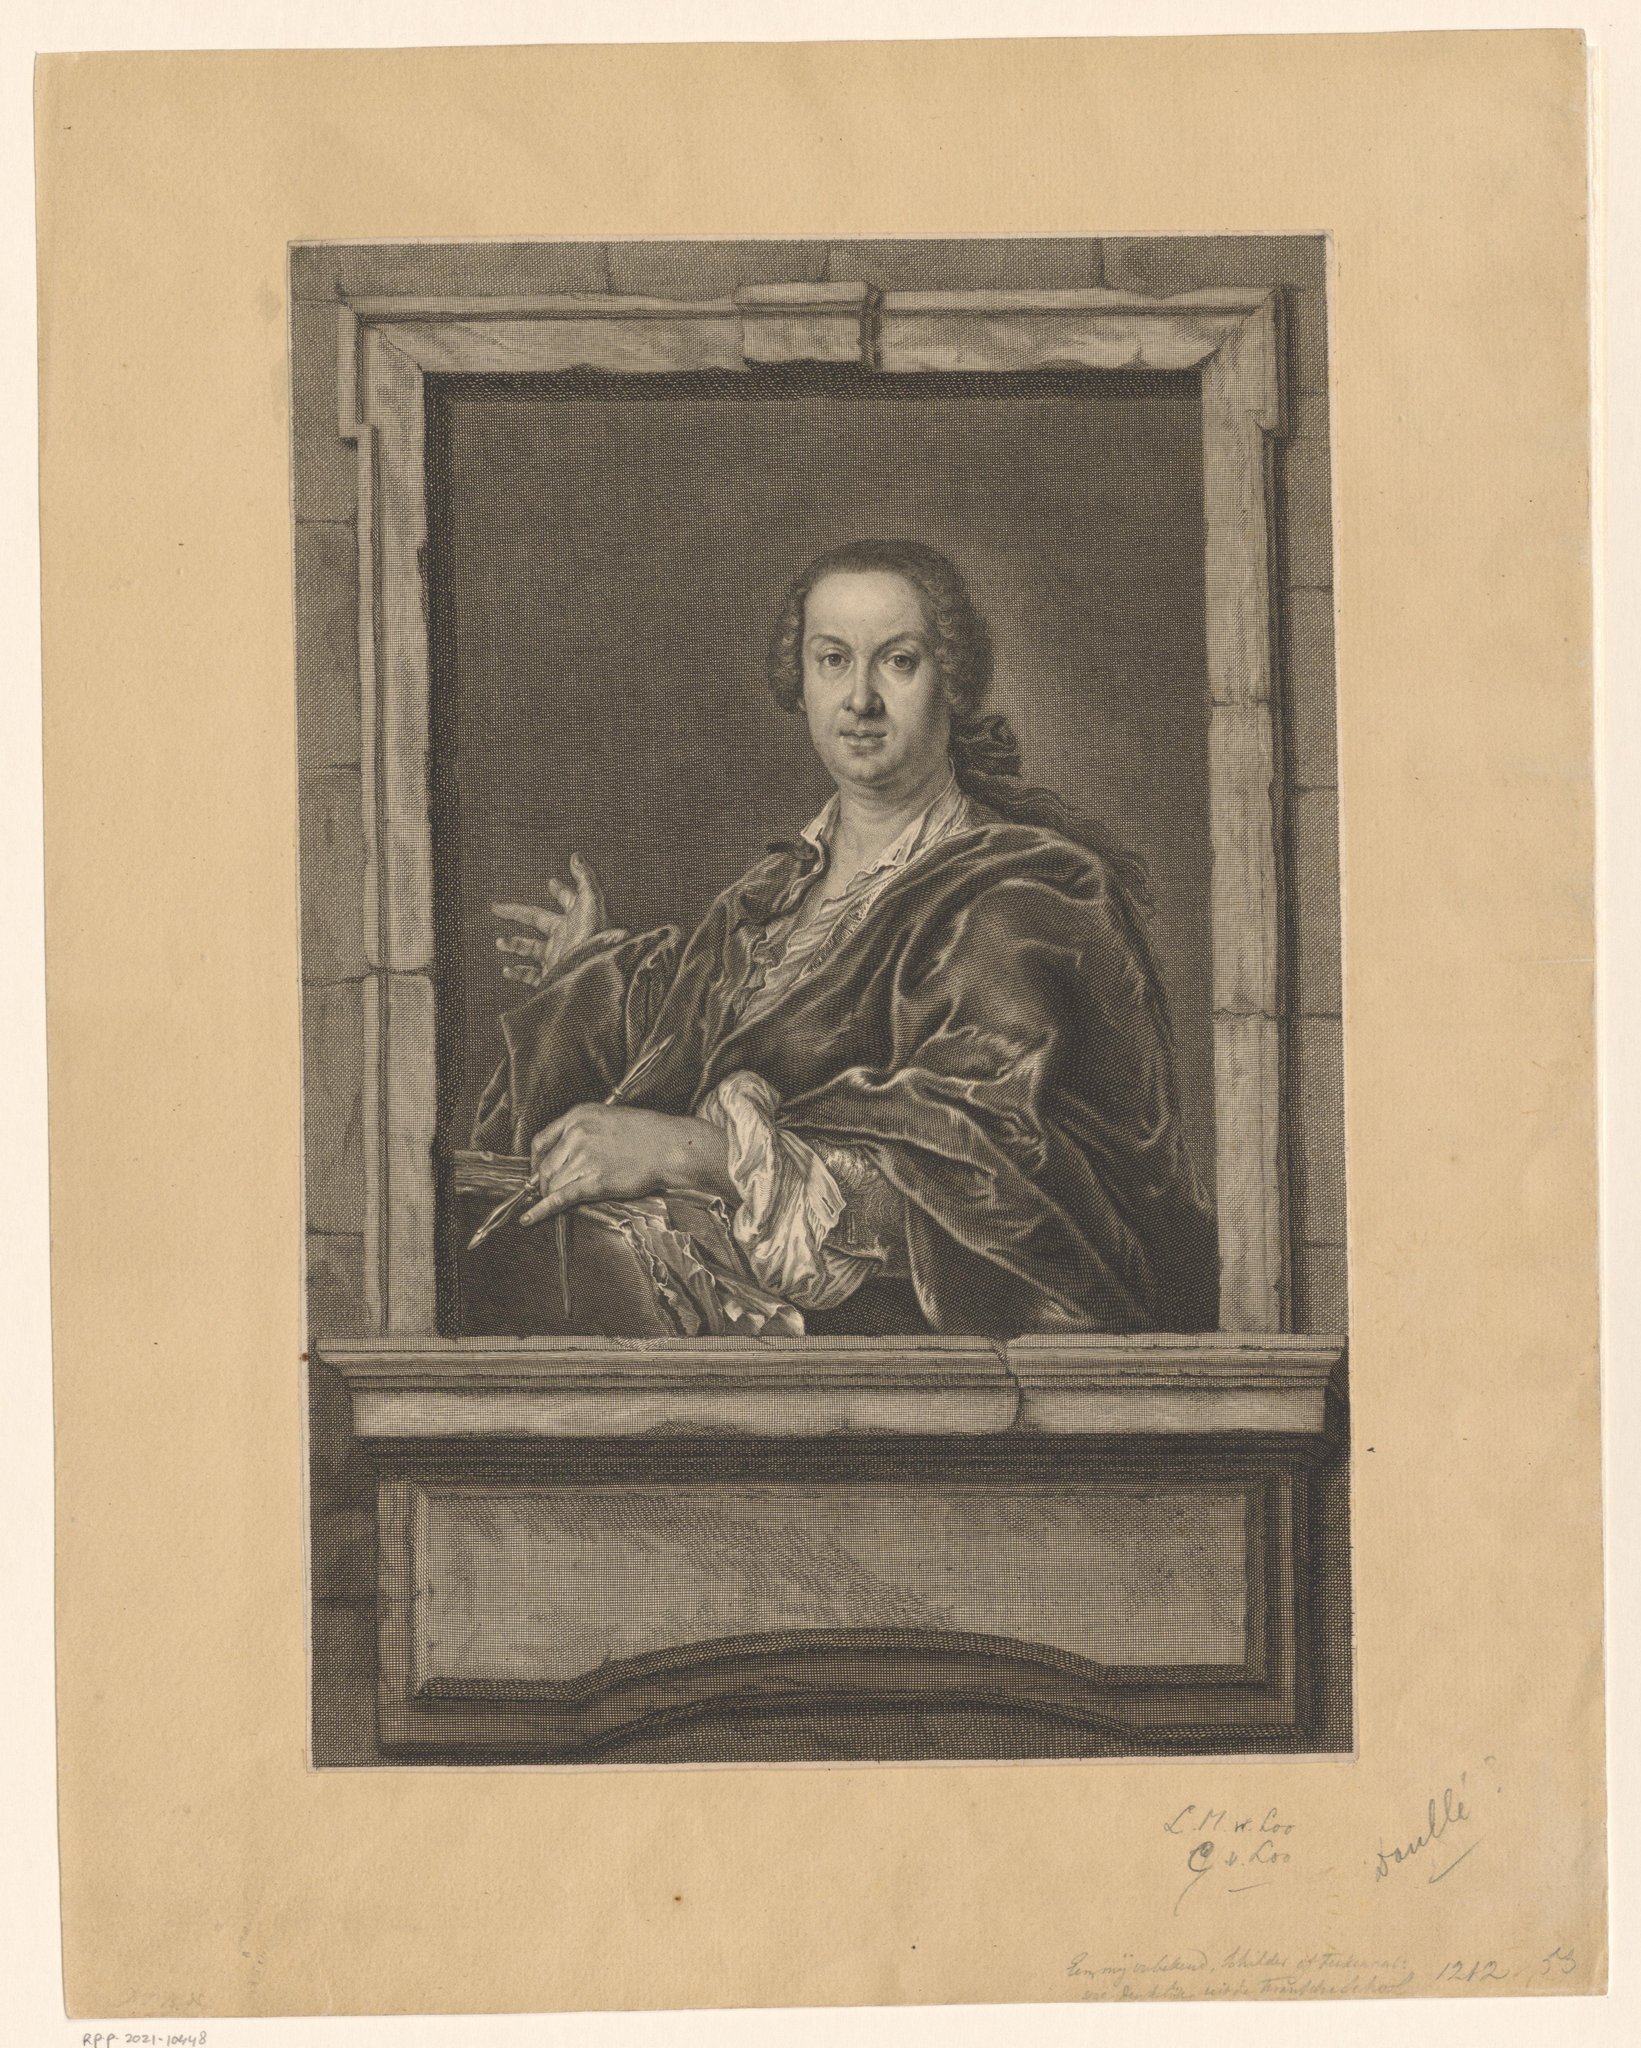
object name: print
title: Portret van een onbekende man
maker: Anonymous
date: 1700-1799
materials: paper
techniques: engraving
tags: adult man, historical persons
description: Portret van een verder onbekende man, mogelijk met de naam Van Loo.